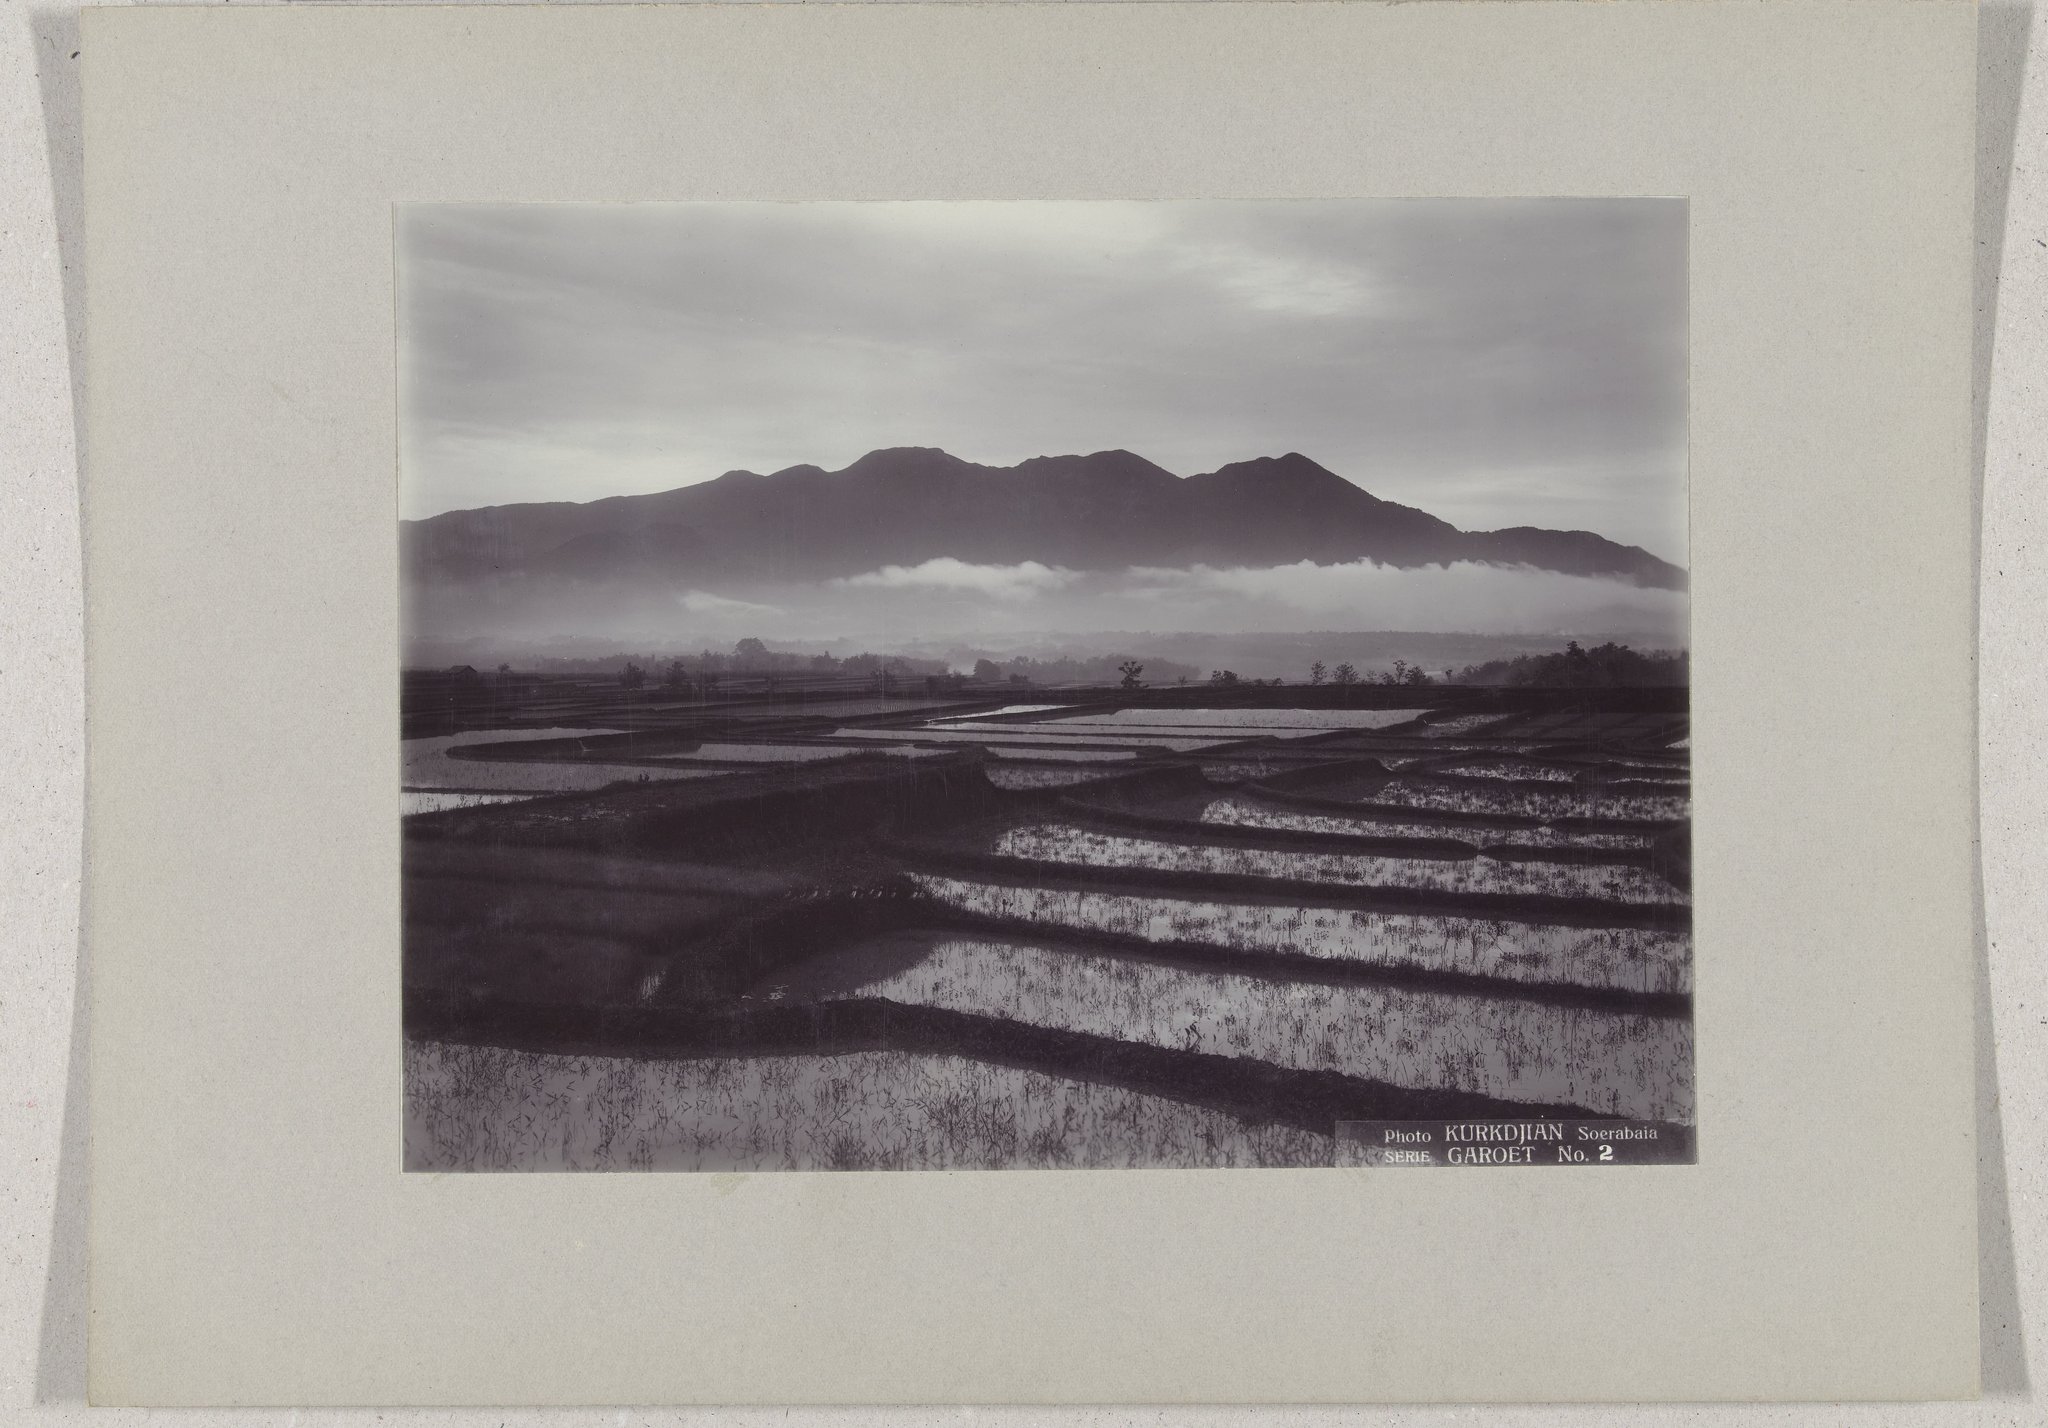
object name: photograph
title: Rijstvelden bij de Goentoer, nabij Garoet, Nederlands-Indië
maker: onnes kurkdjian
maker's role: fotograaf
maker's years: 1851-1903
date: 1895-1915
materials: cardboard, paper, photographic support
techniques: gelatin silver print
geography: garut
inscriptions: annotation: ‘62. Goentoer’, name: ‘Photo Kurkdjian Soerabaia / Serie Garoet No. 2’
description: Rijstvelden bij de Goentoer, nabij Garoet, Nederlands-Indië